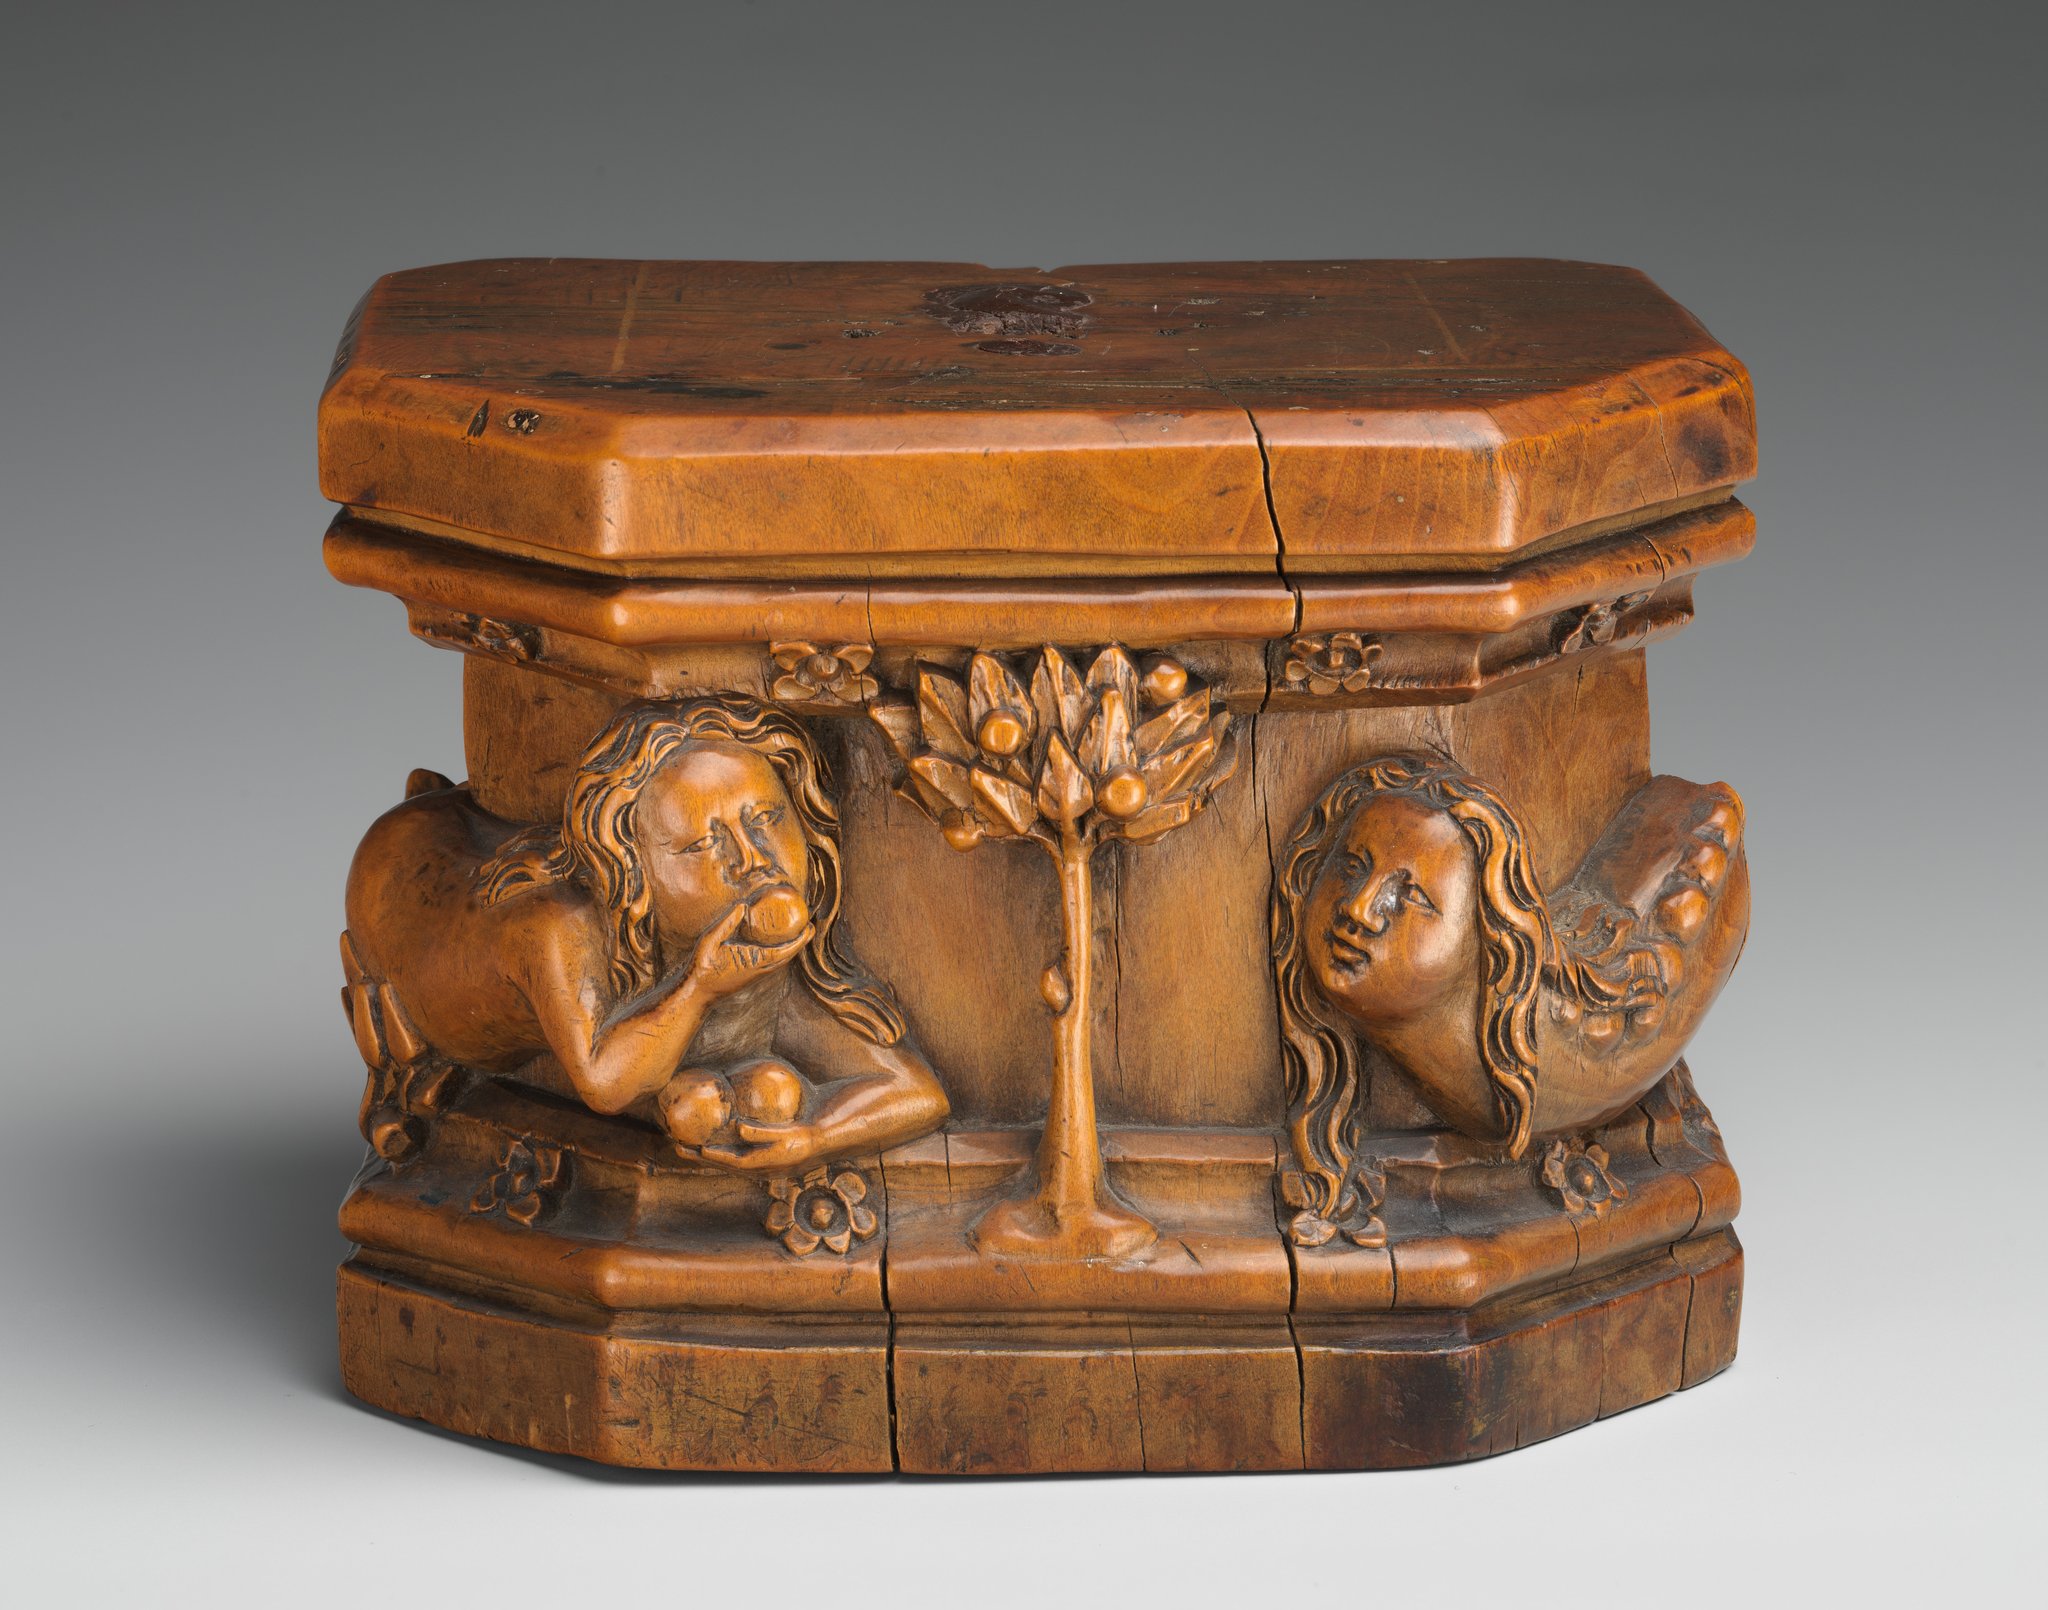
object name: statuette base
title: Base for a Statuette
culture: south netherlandish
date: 1470-1480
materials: wood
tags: fruit,serpents,eve